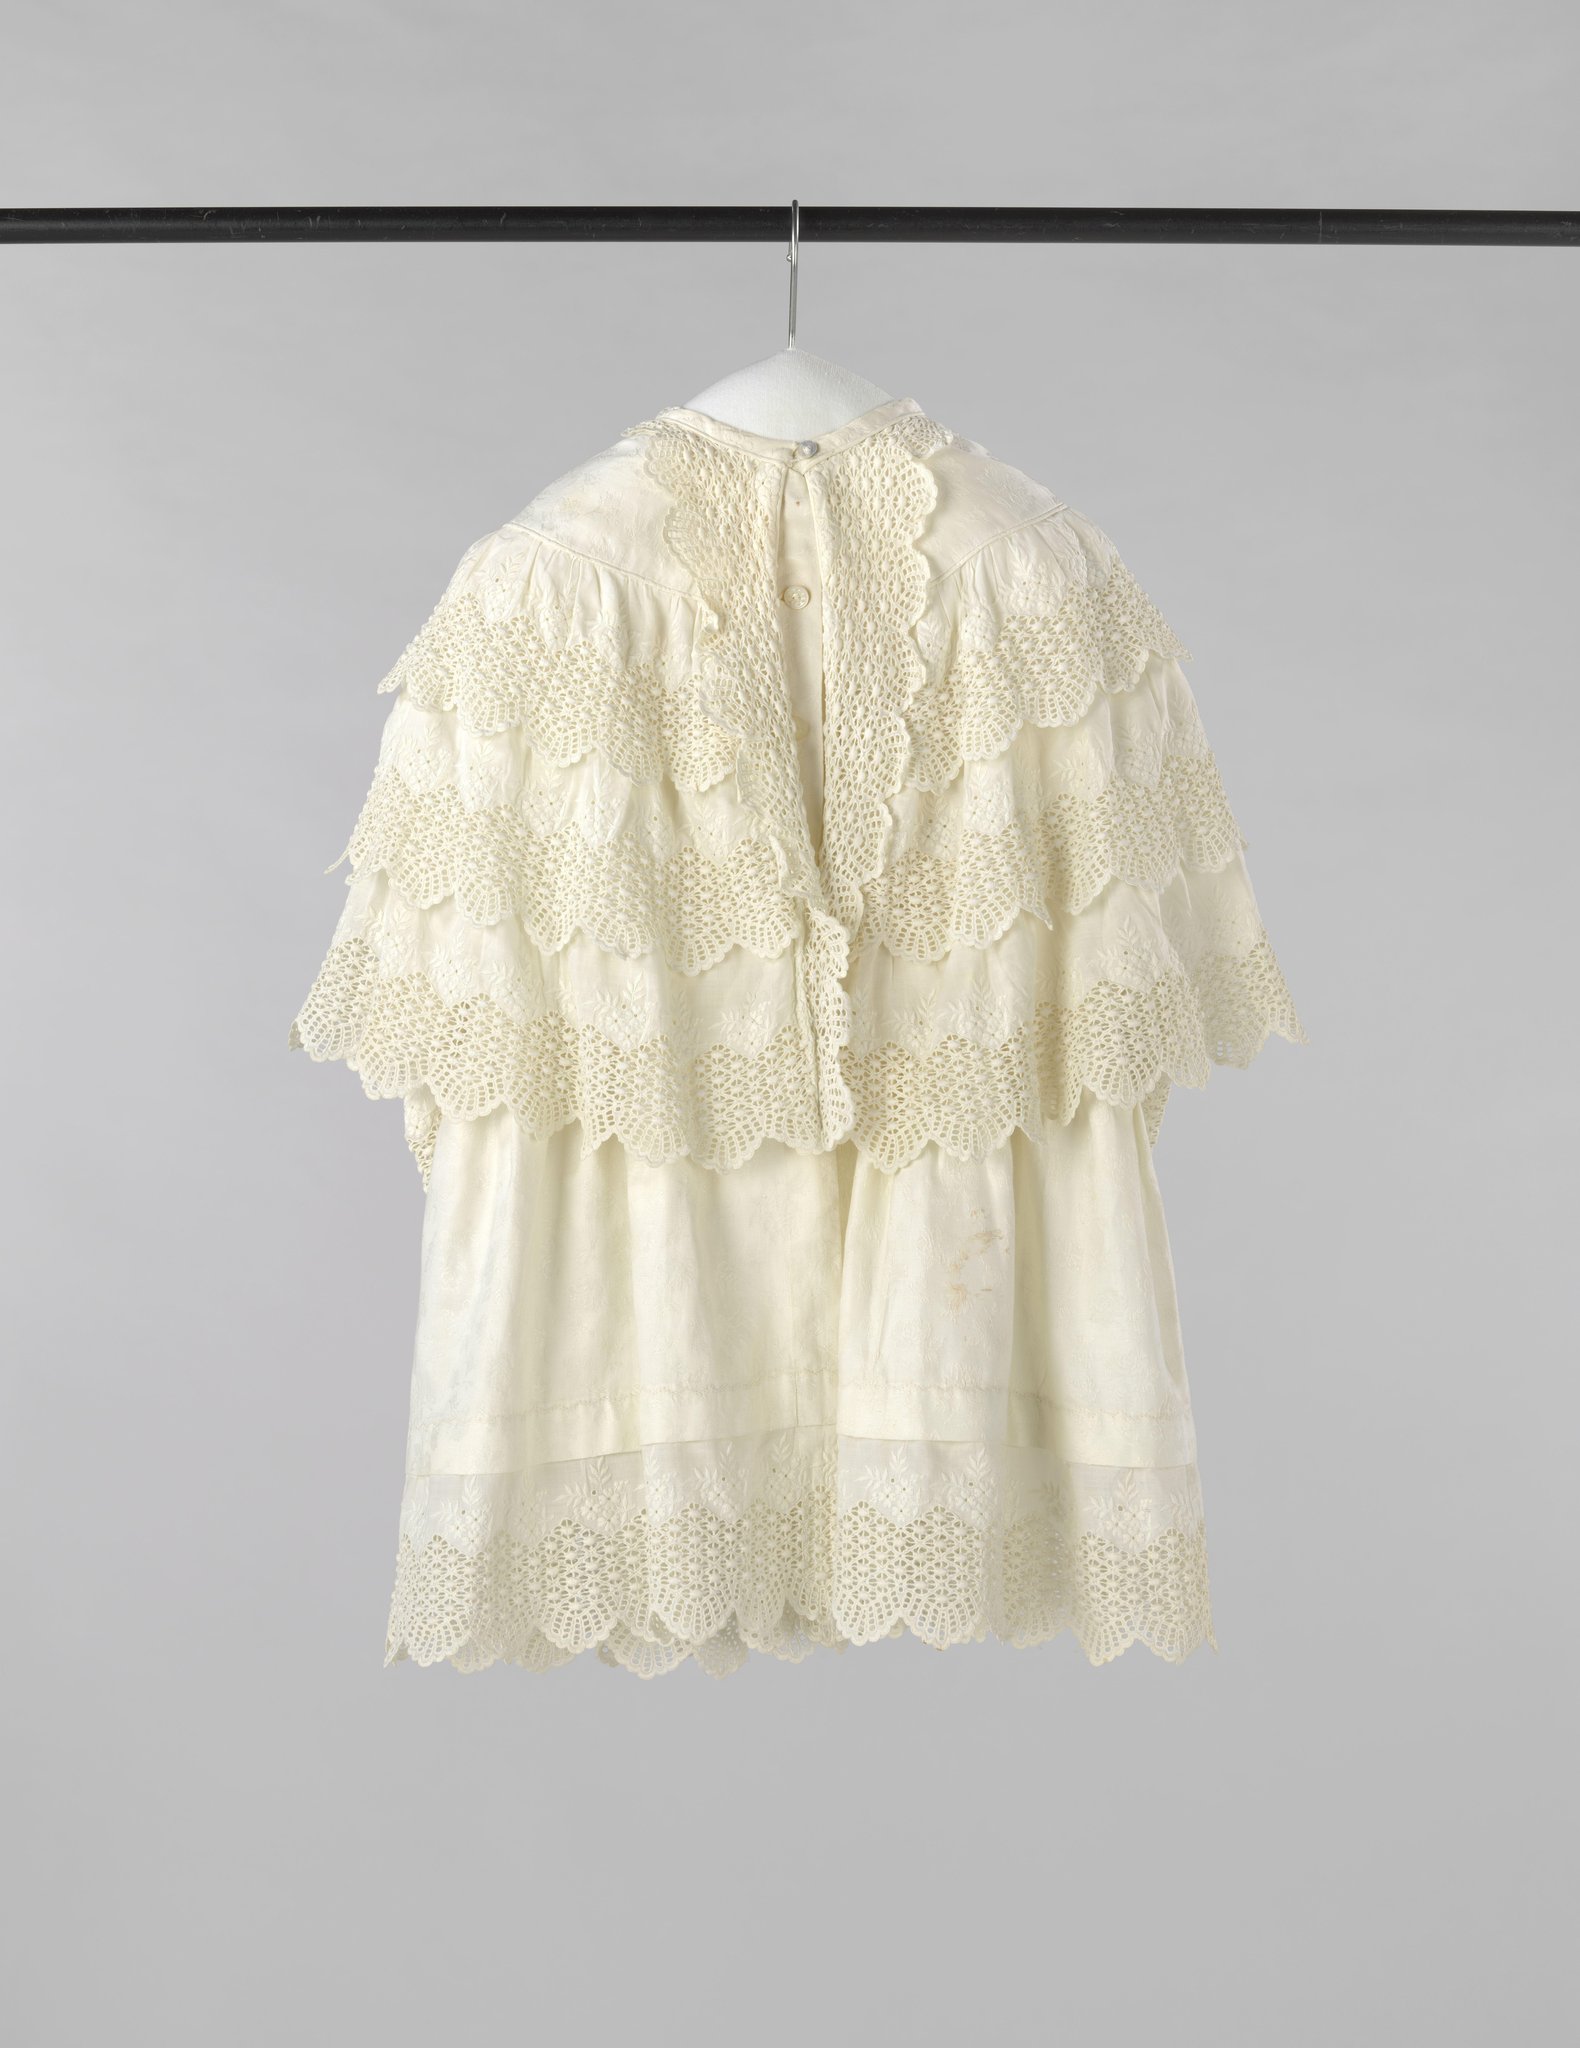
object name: coat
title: Wagenjas, voor jongens en meisjes, van katoenen damast voorzien van een driedubbele pelerien van stroken Engels borduurwerk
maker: Anonymous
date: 1900-1910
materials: cotton, mother of pearl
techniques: english embroidery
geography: brussels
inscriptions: initials: ‘P.’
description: Een wagenjas, voor jongens en meisjes, van katoenen damast voorzien van een driedubbele pelerien van stroken Engels borduurwerk. Eind Belle Époque of Victoriaans. Met voorstelling met reliëf-parelmoeren knoopjes.